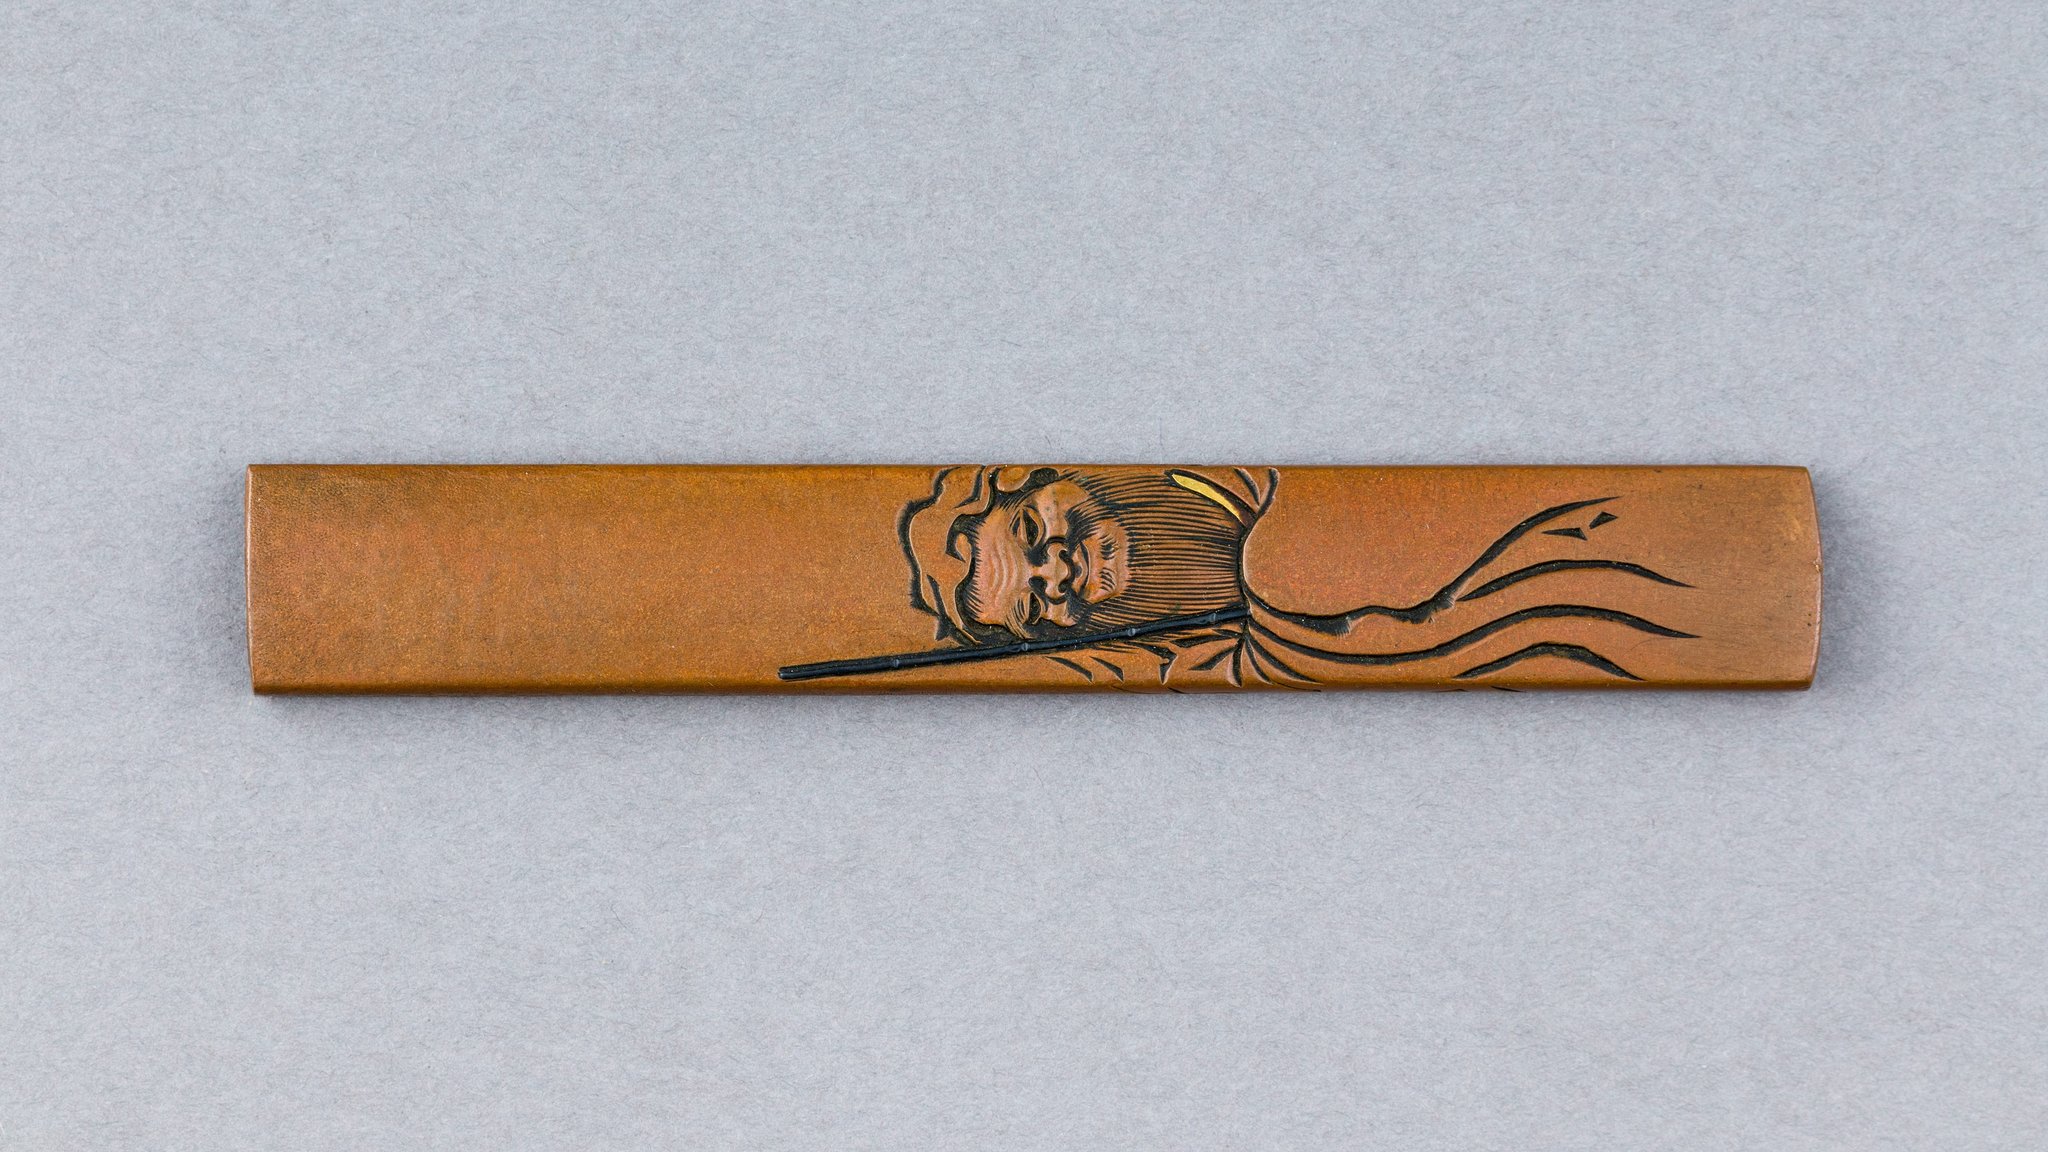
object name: knife handle kozuka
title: Knife Handle (Kozuka)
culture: japanese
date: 1615-1868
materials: copper, gold alloy, gold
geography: japan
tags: men